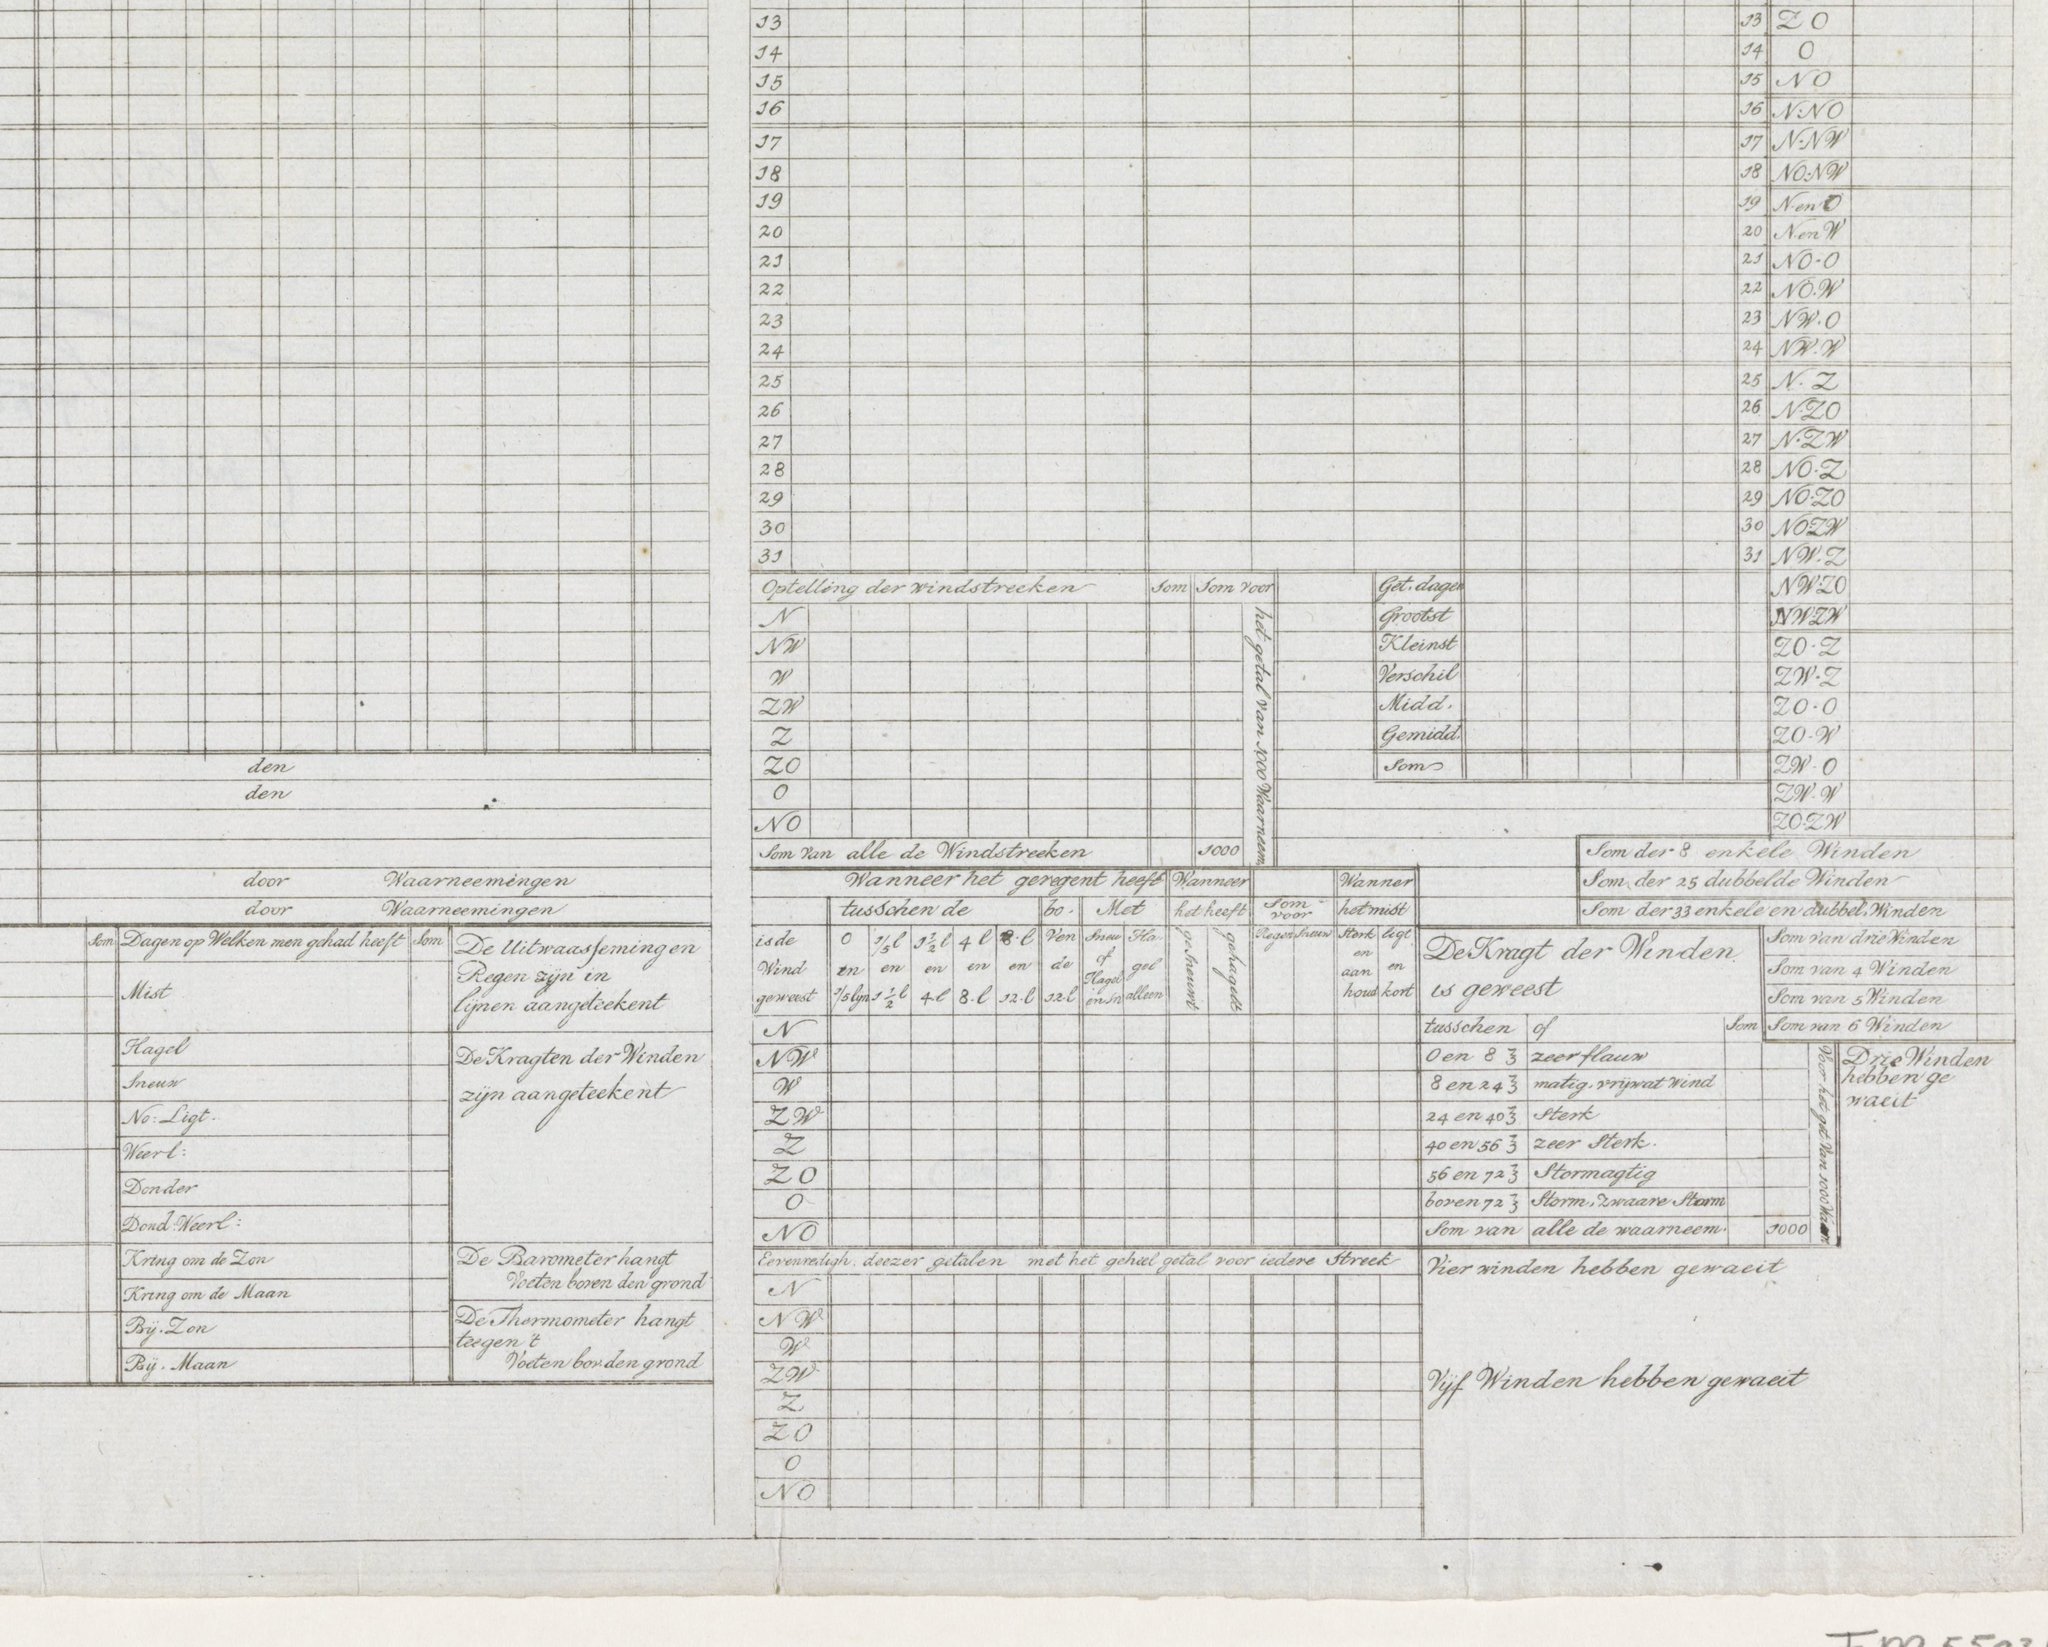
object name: form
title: Weêrkundige Waarneemingen gedaan te (...) in de Maand (...) 17.. door (...)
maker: Anonymous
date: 1790-1799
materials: paper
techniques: engraving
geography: netherlands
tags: meteorology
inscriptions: collector's mark: Lugt 2228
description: Oningevulde tabel voor het vastleggen van meteorologische waarnemingen, eind 18e eeuw.